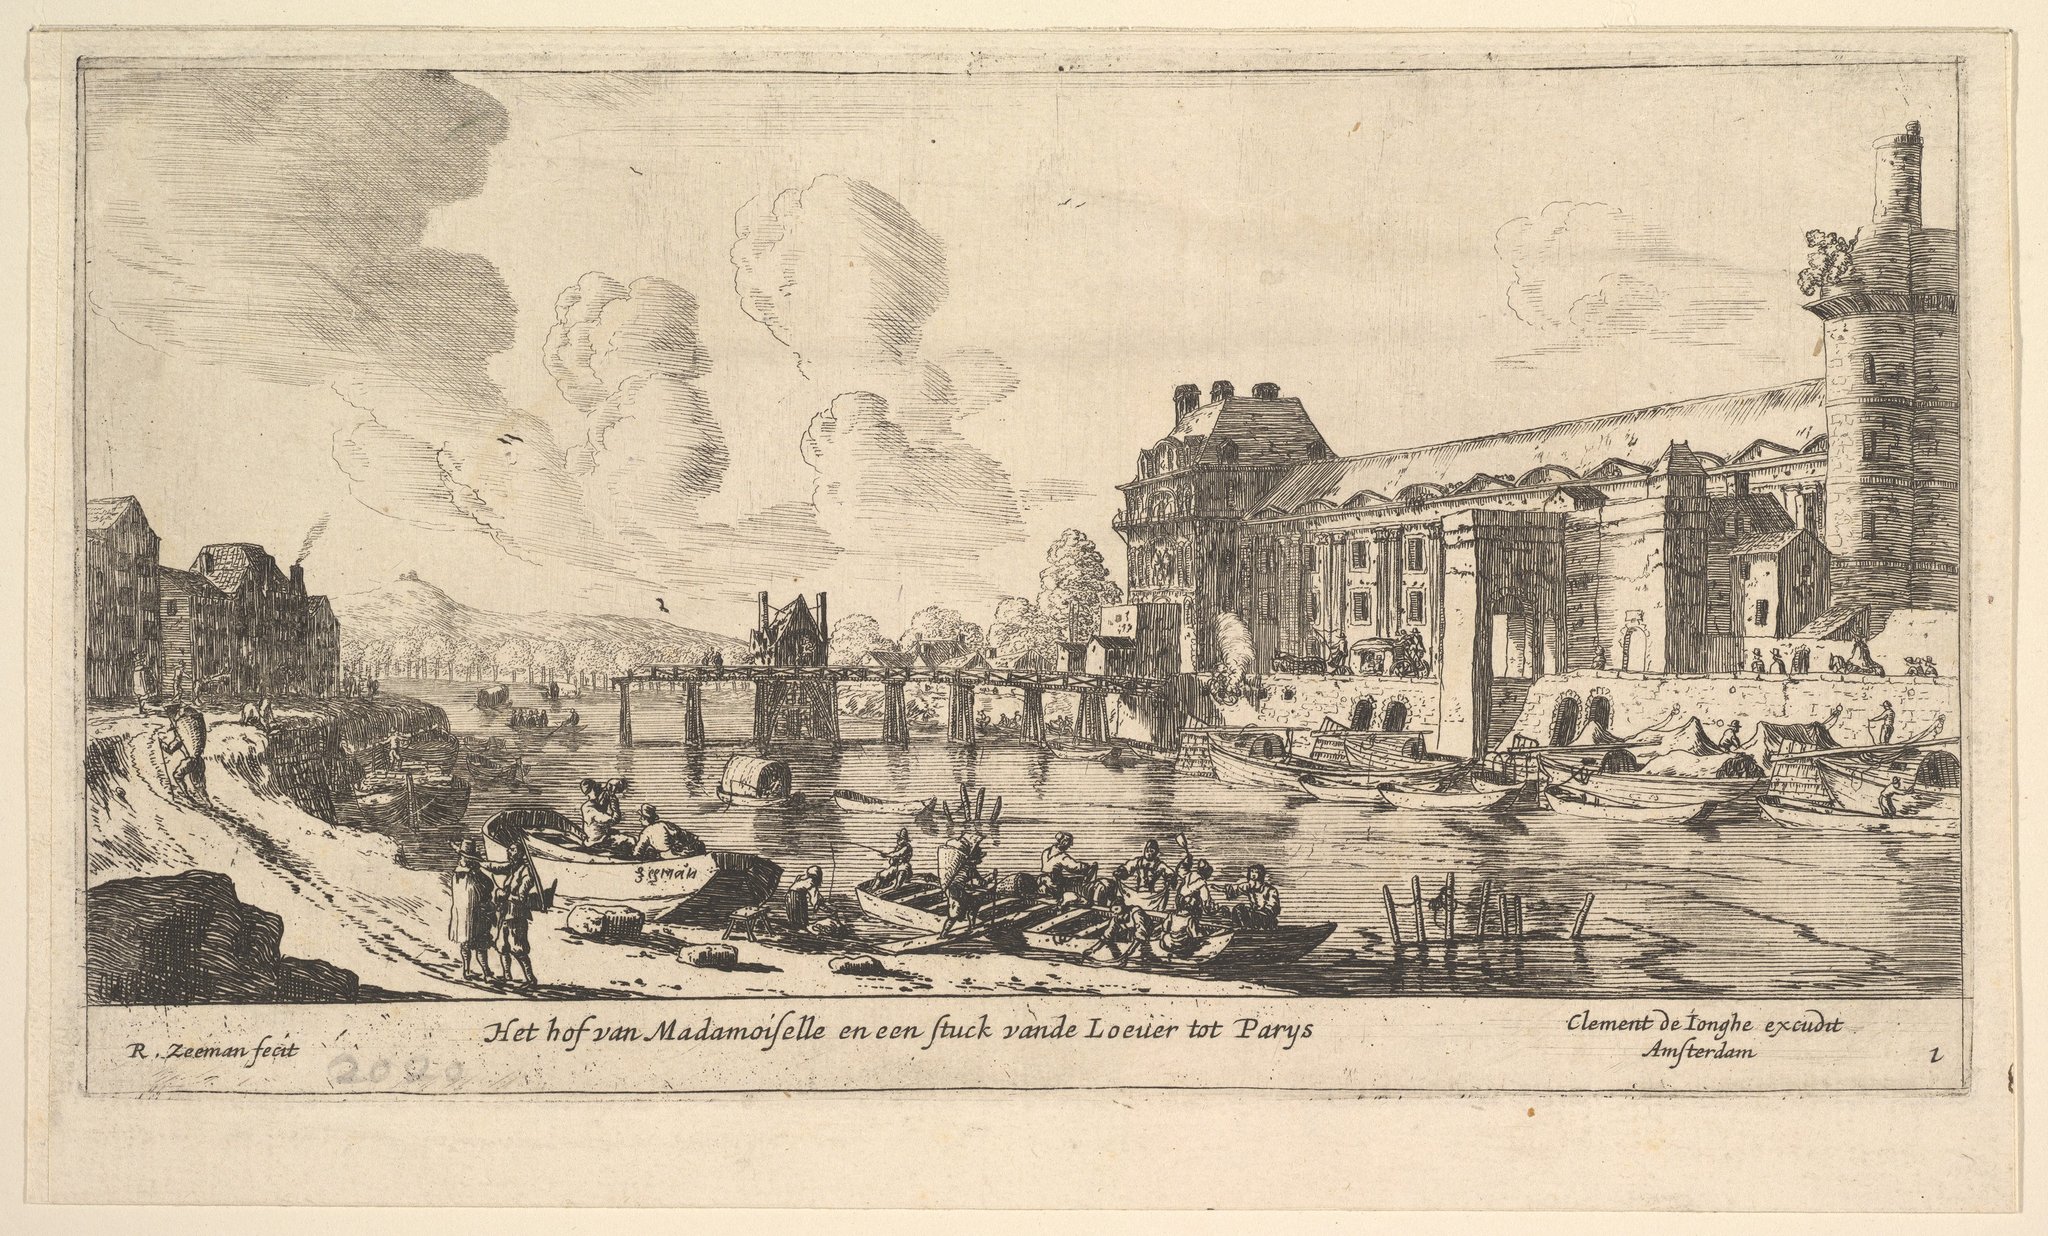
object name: print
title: View of the Louvre and the Tuileries, from Views of Paris and Neighborhoods, plate 1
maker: reinier nooms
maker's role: artist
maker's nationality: dutch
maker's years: 1623-1664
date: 1601-1700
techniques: drypoint, etching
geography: france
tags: buildings,bridges,rivers,boats,paris